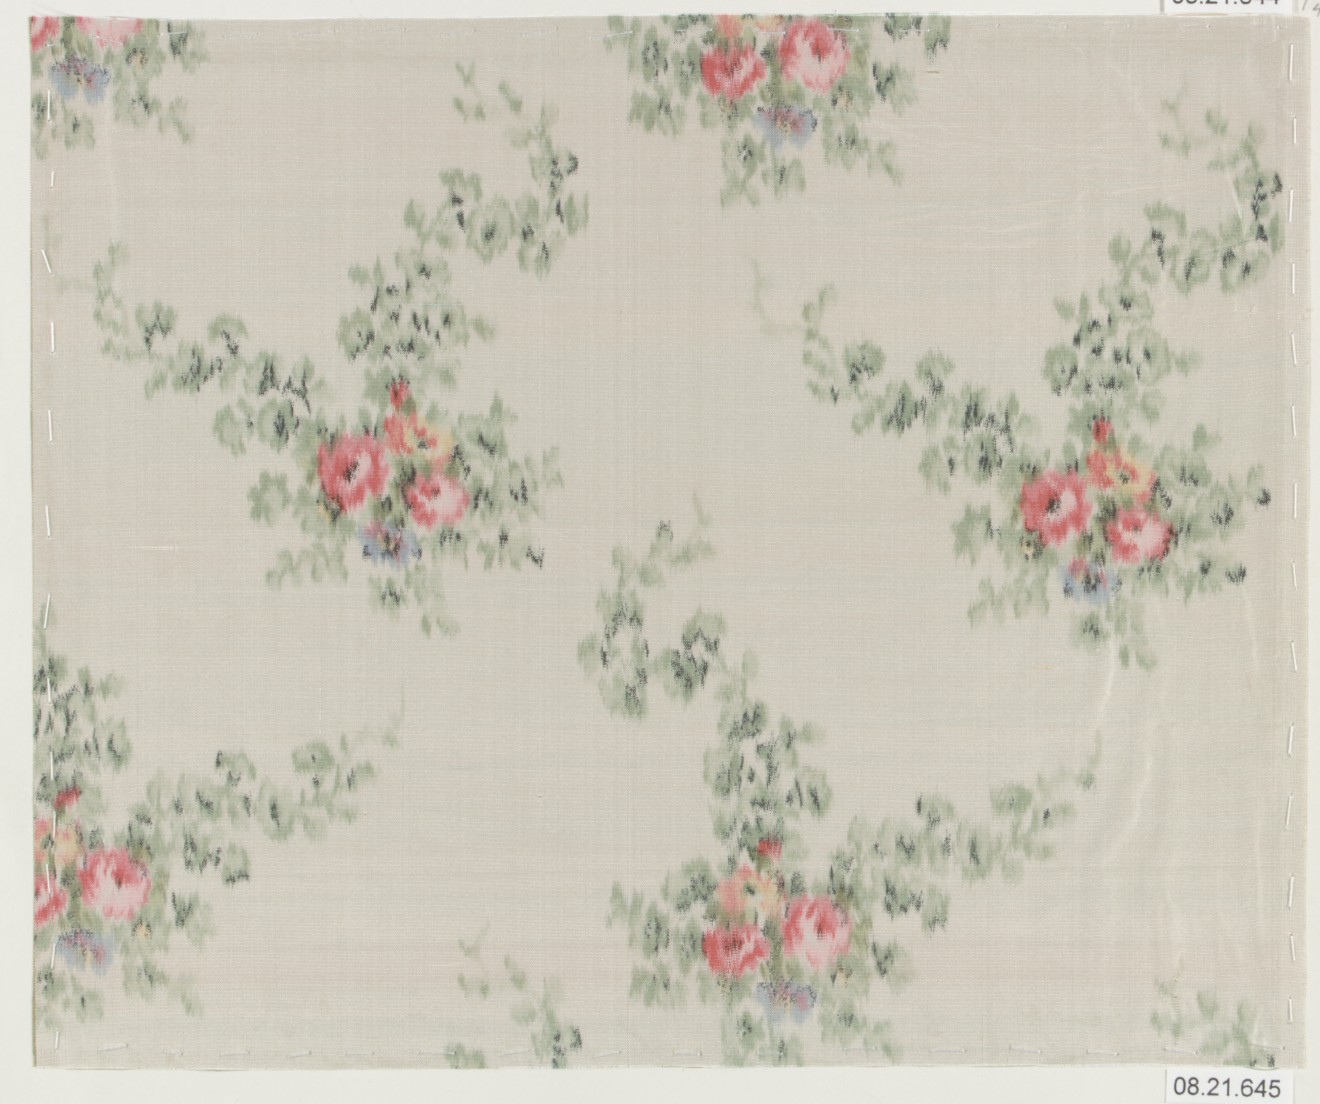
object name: textile sample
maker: Anonymous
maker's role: designer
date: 1900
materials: silk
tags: flowers